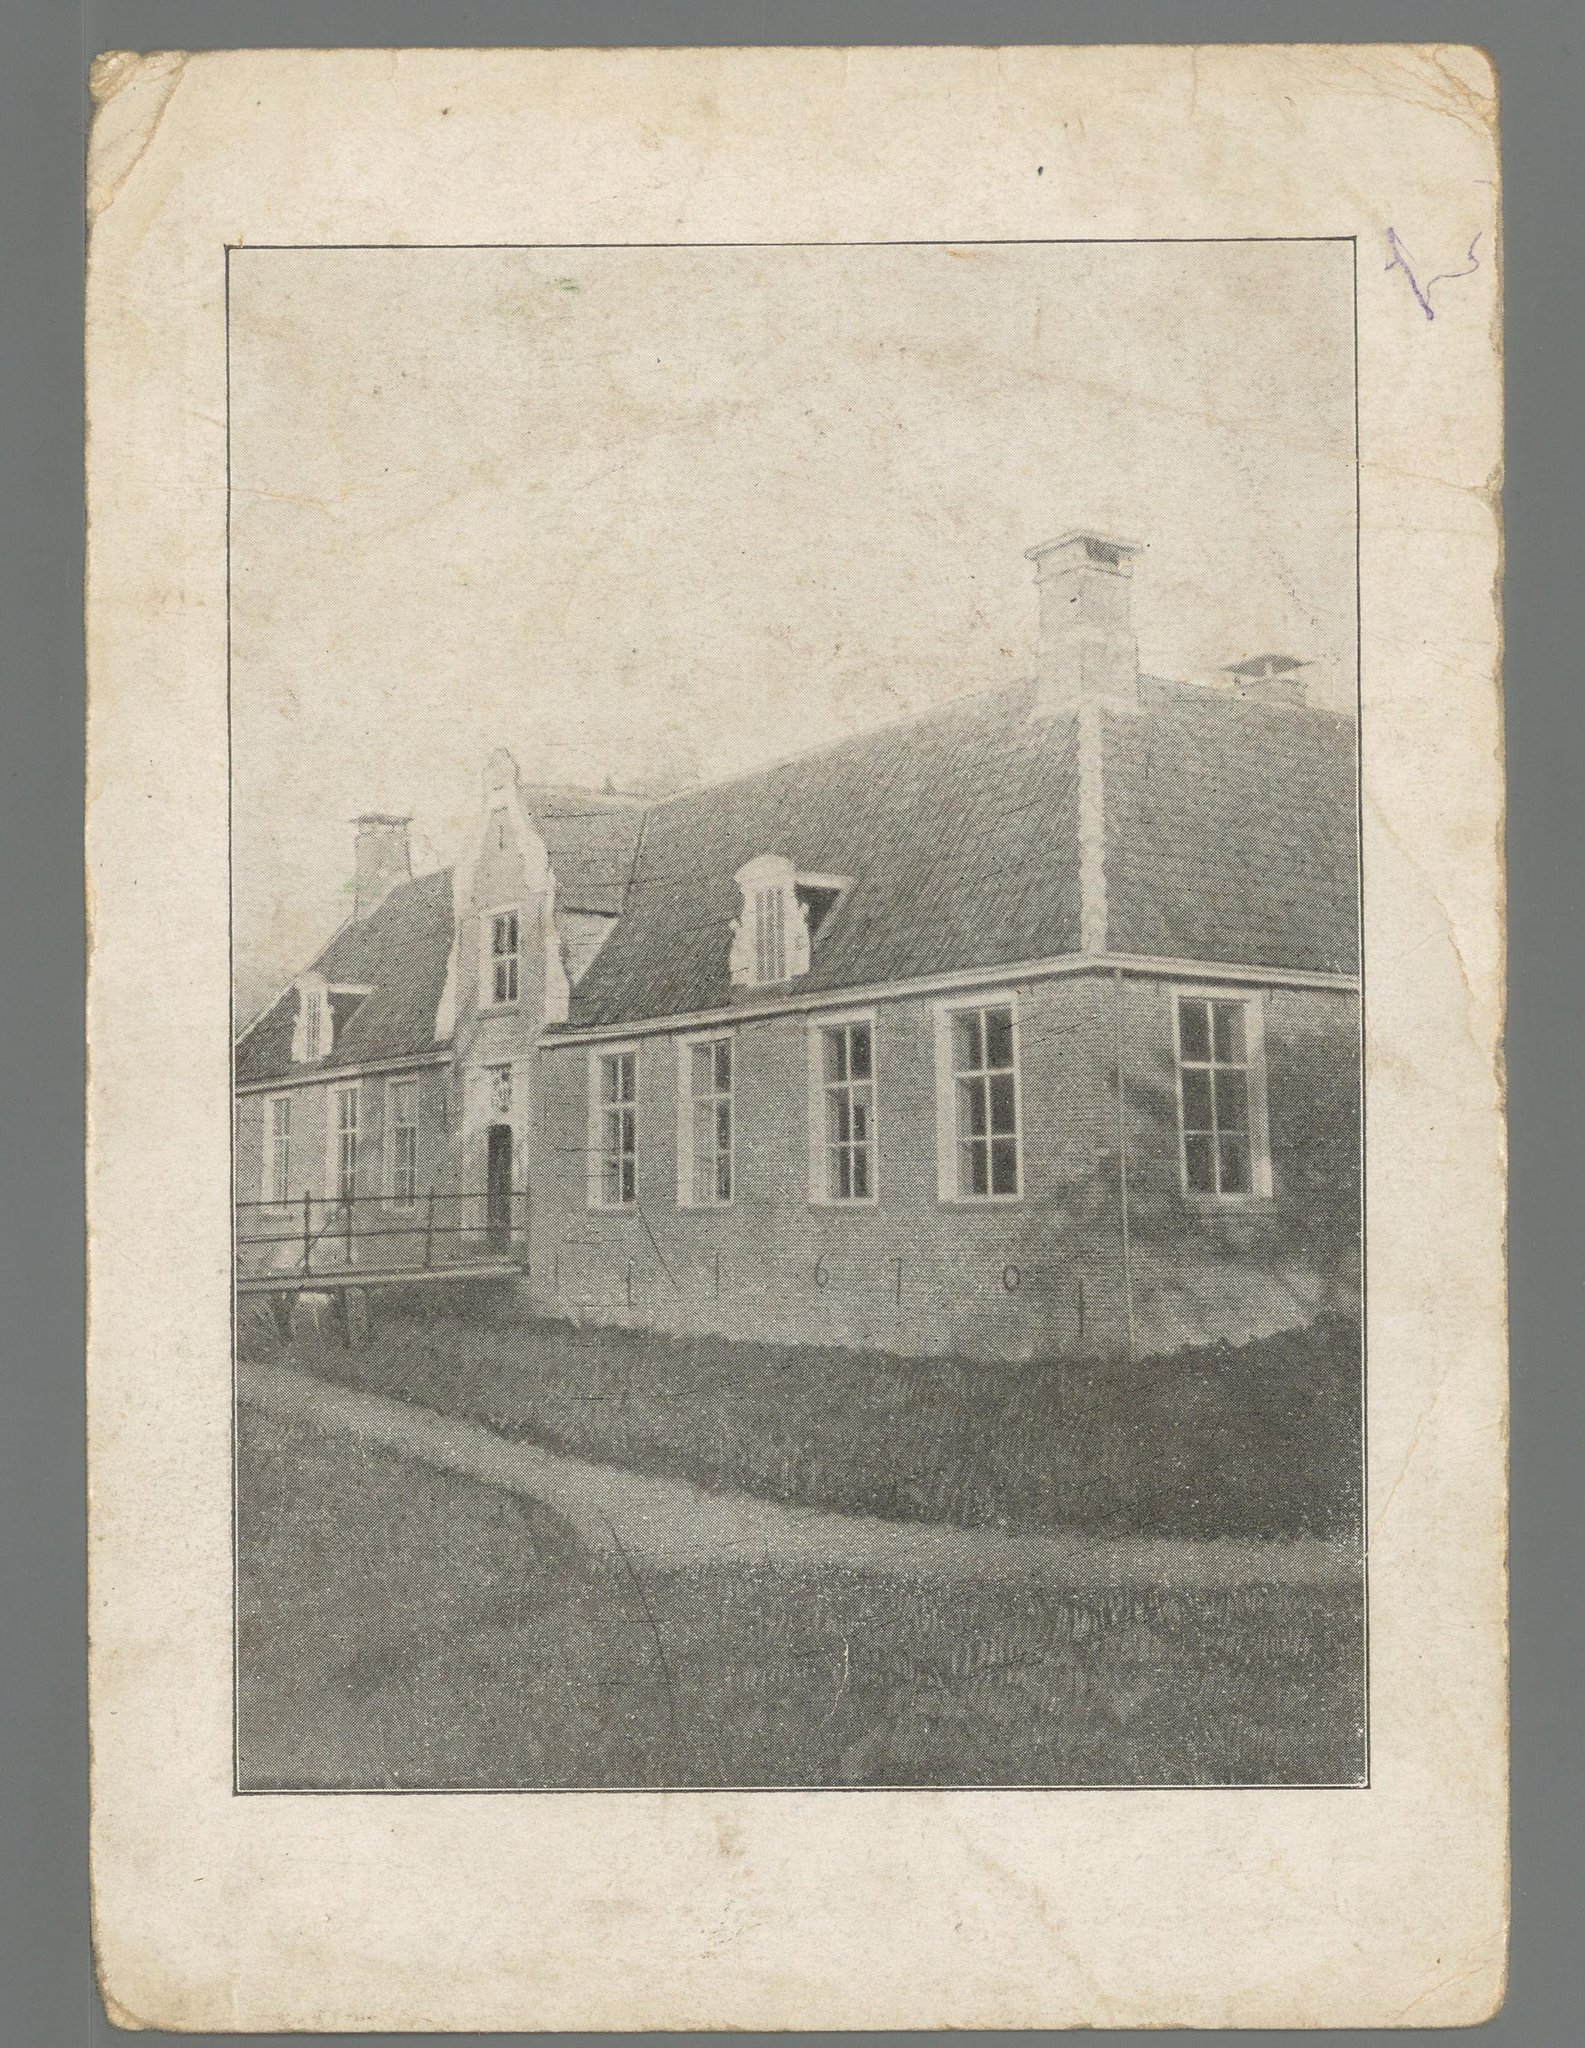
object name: photomechanical print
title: JEUGDBOND VOOR ONTHOUDING (...)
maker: Anonymous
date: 1919-1930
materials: cardboard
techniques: writing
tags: farm or solitary house in landscape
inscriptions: poststempel, verso, gestempeld